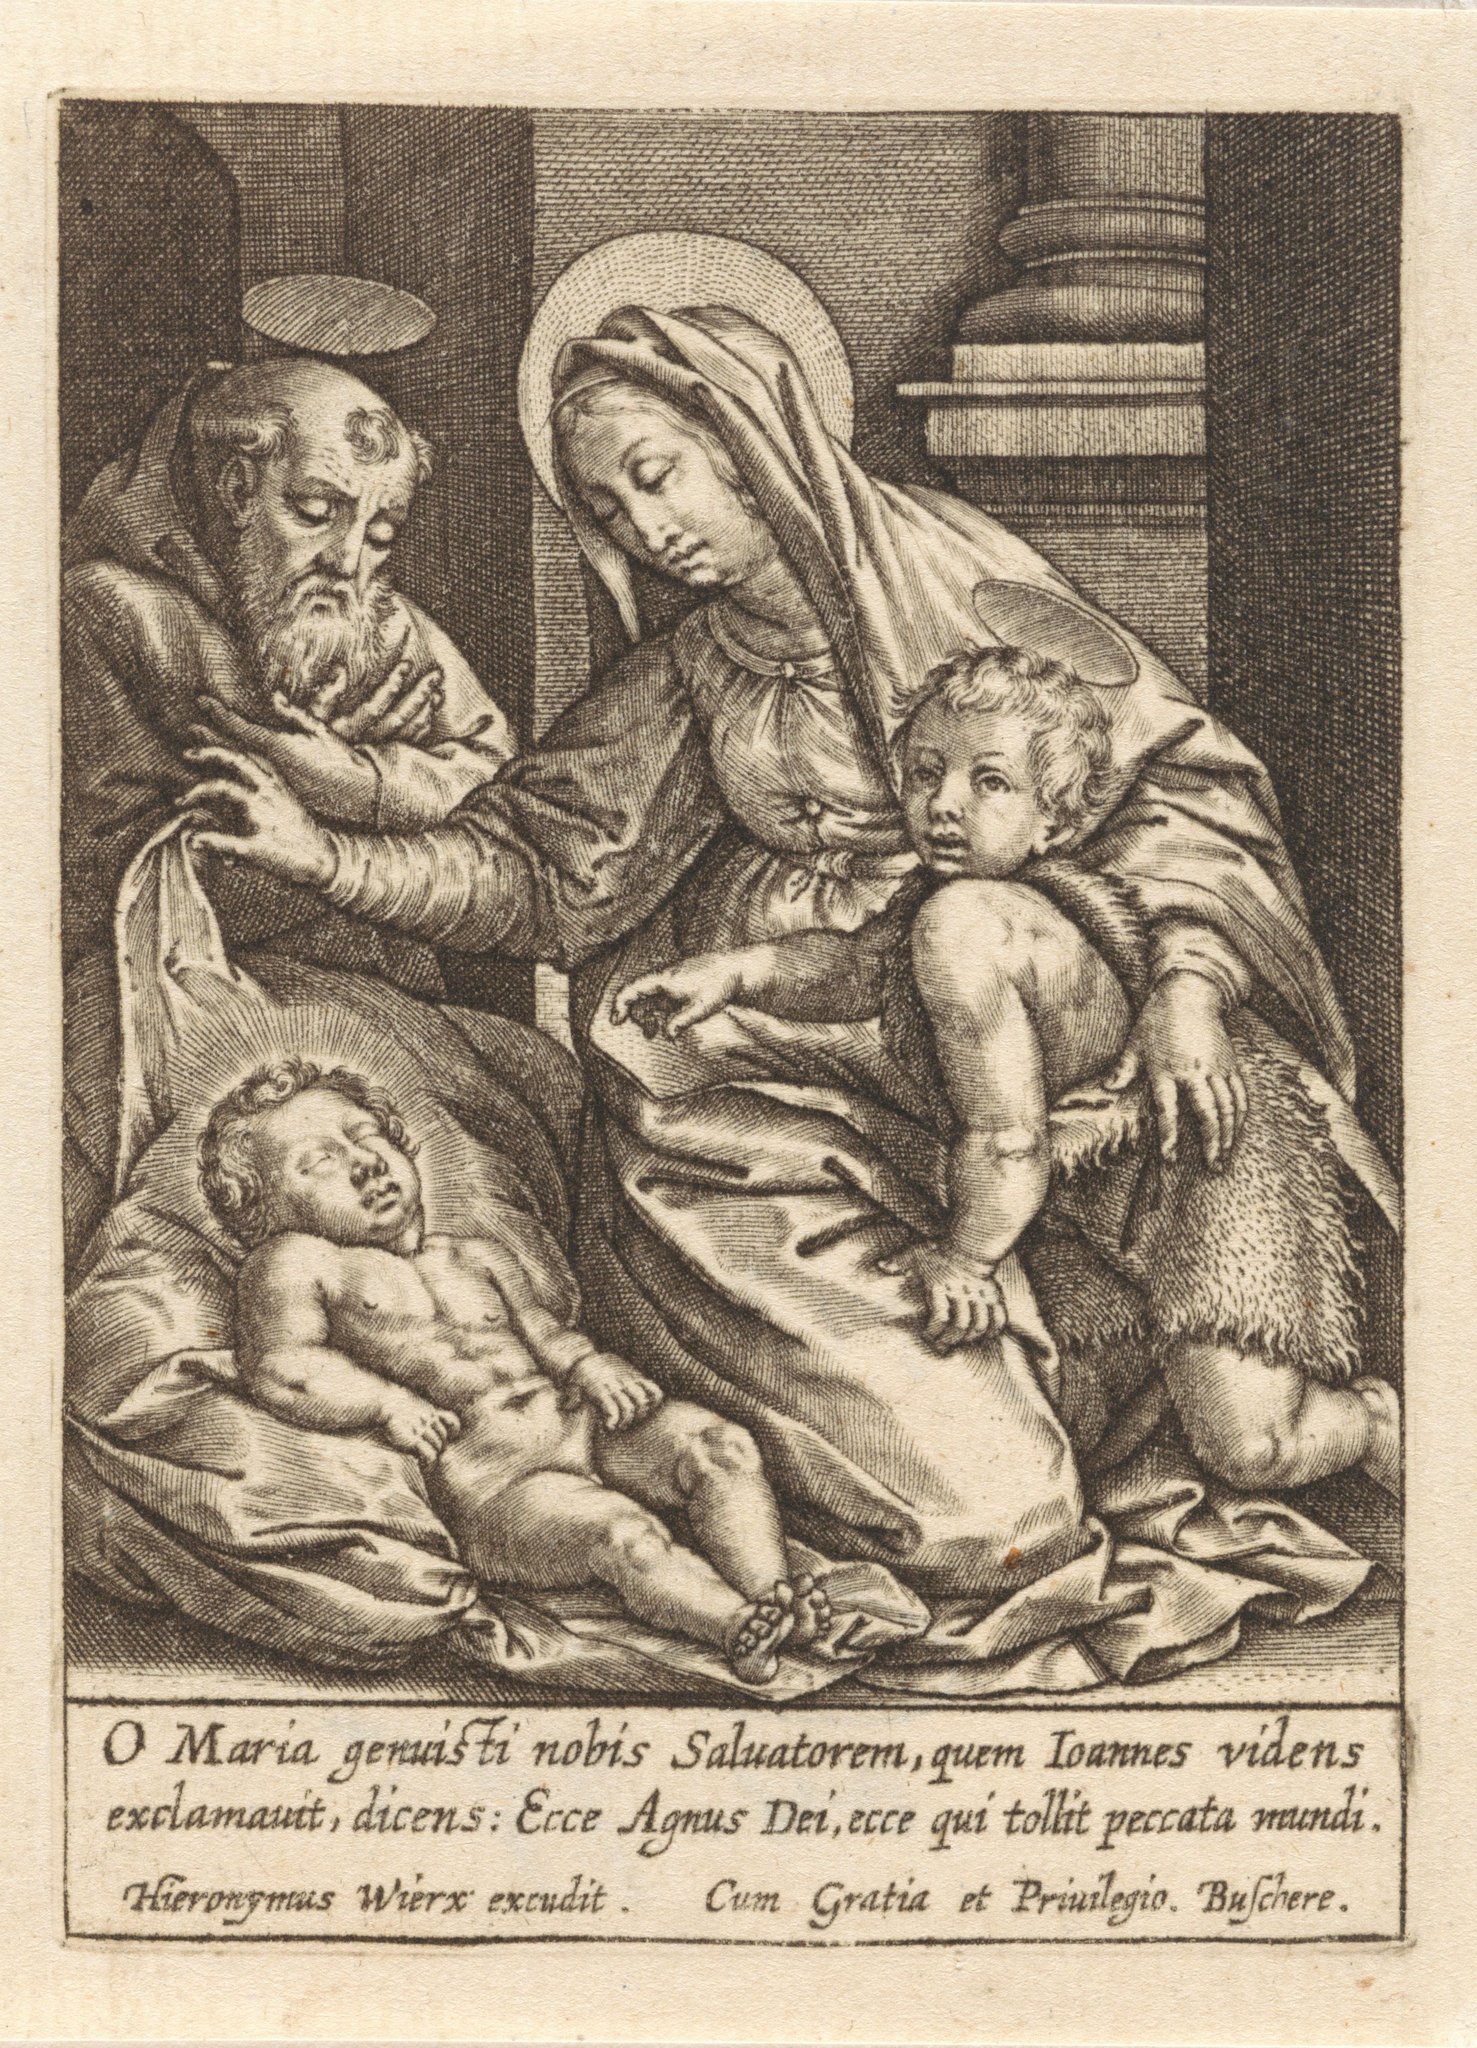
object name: print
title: Heilige Familie bij het slapende Christuskind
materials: paper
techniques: engraving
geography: antwerp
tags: holy family with john the baptist (as child), sleeping; unconsciousness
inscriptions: collector's mark: Lugt 2228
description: Maria tilt het laken op van het slapende Christuskind. Ze heeft haar arm om de jonge Johannes de Doper heen geslagen. Jozef zit achter het Kind, de armen gevouwen voor zijn borst. In de marge een tweeregelig onderschrift in het Latijn.